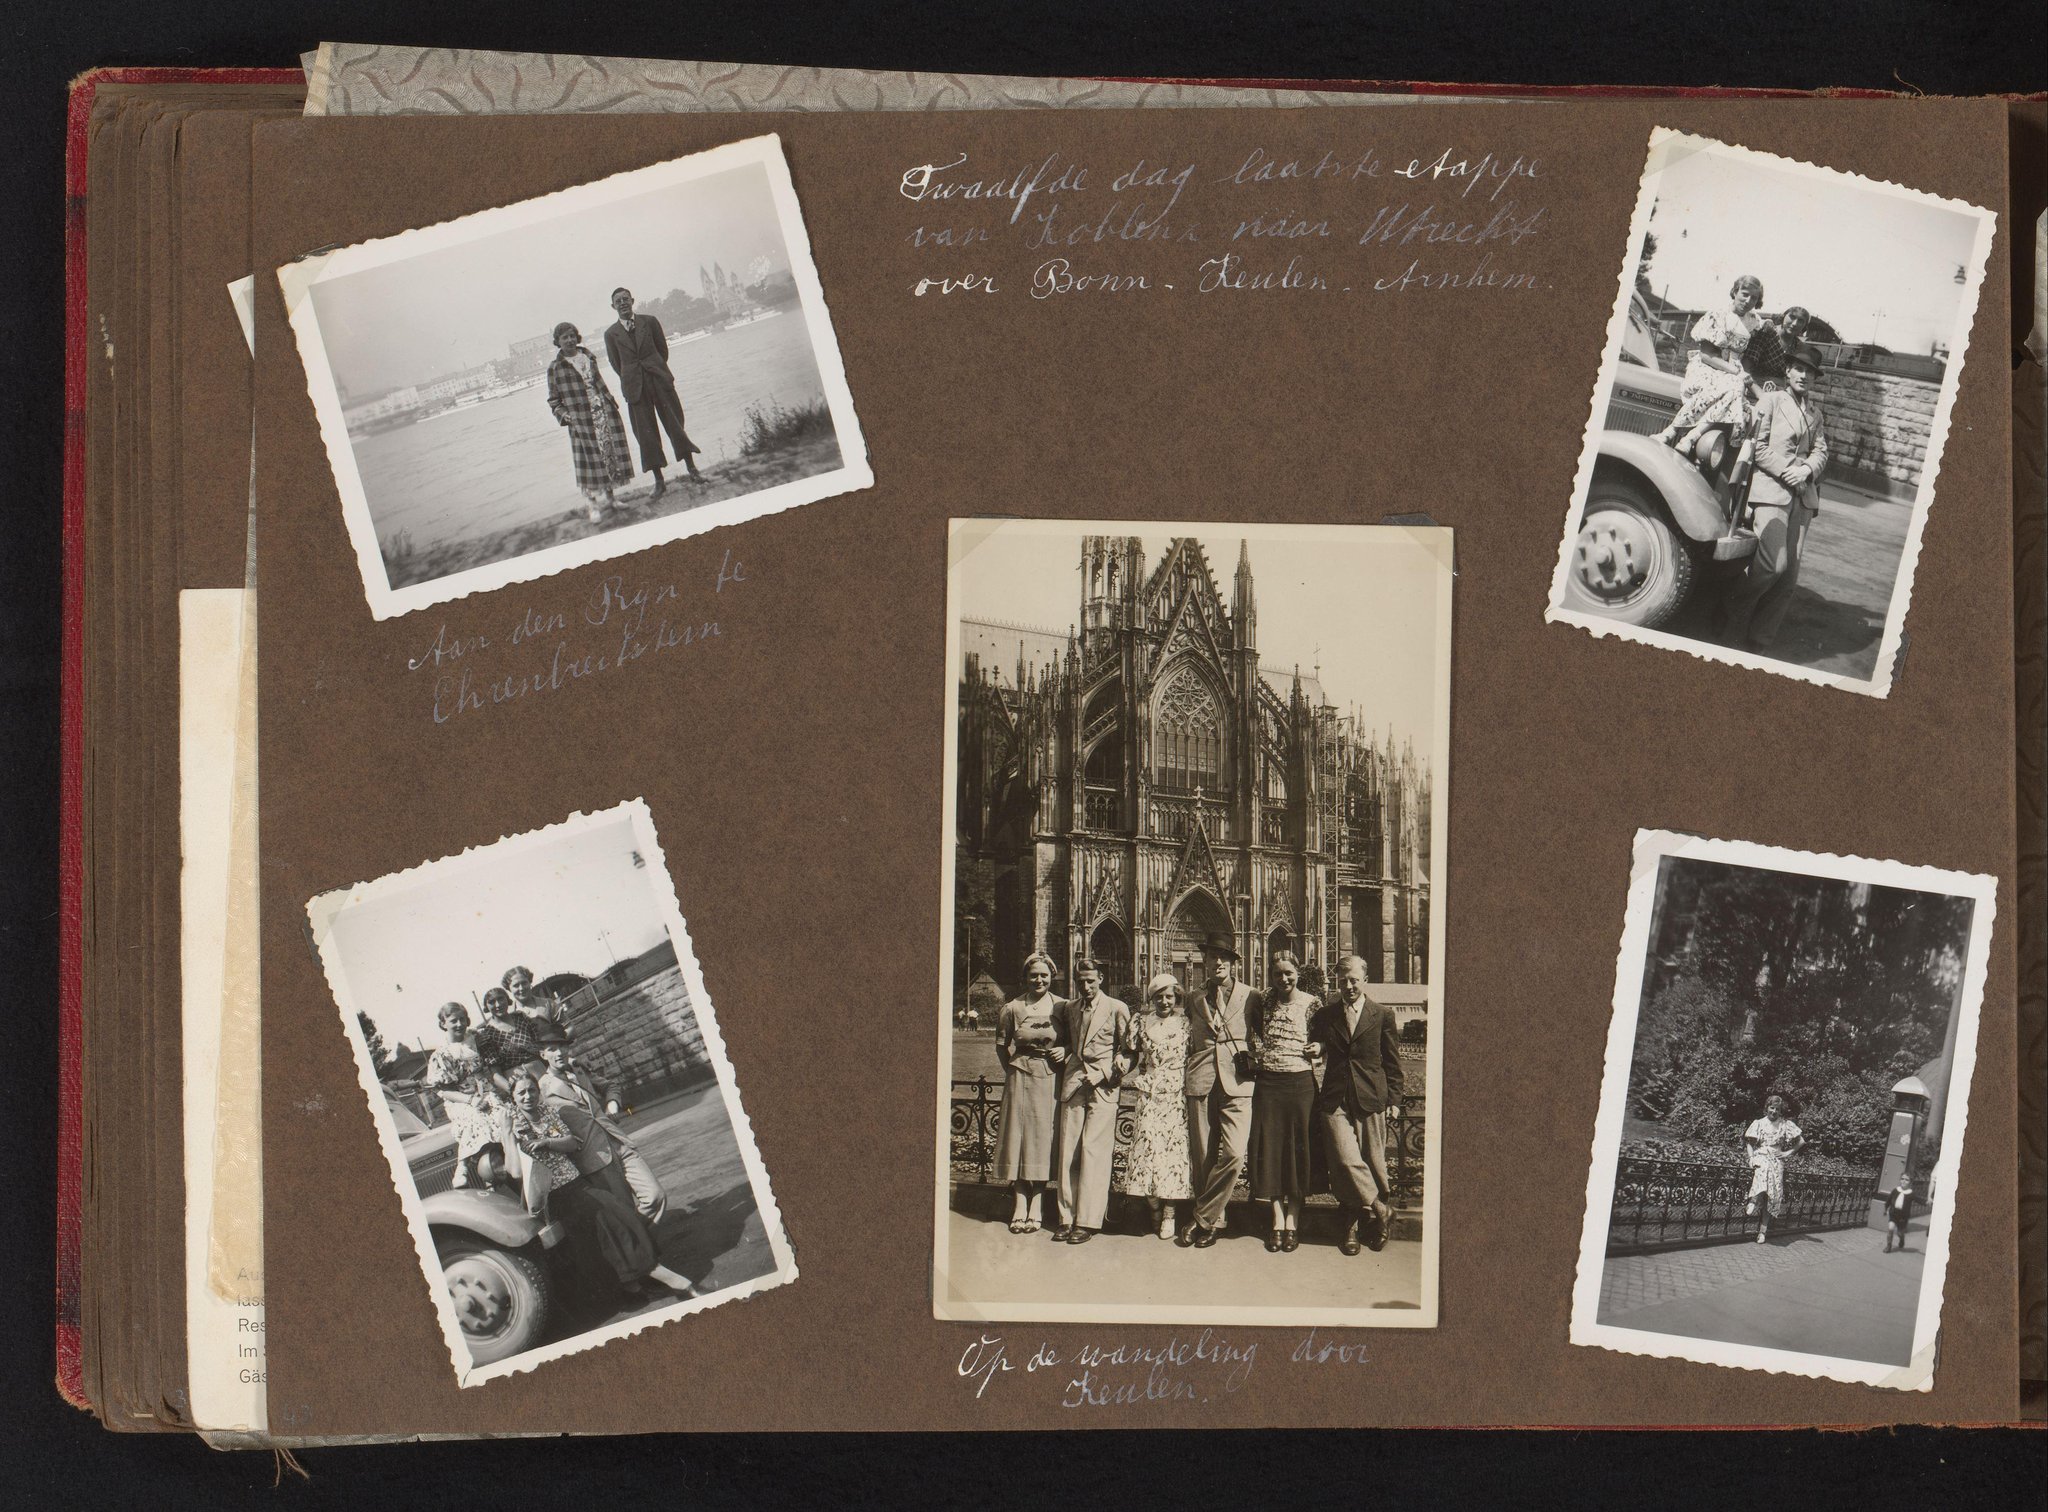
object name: photograph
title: Twaalfde dag laatste etappe van Koblenz naar Utrecht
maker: Anonymous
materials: paper, photographic support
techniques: gelatin silver print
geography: cologne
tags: outing, pleasure trip, cologne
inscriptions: inscription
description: Albumblad met vijf foto's van enkele leden van het reisgezelschap in Keulen. Verslag van een twaalfdaagse groepsreis per autobus naar Salzburgerland en Beieren van 30 juli tot 10 augustus 1936. Onderdeel van het reisalbum van de familie Van den Broek 1935-1937.